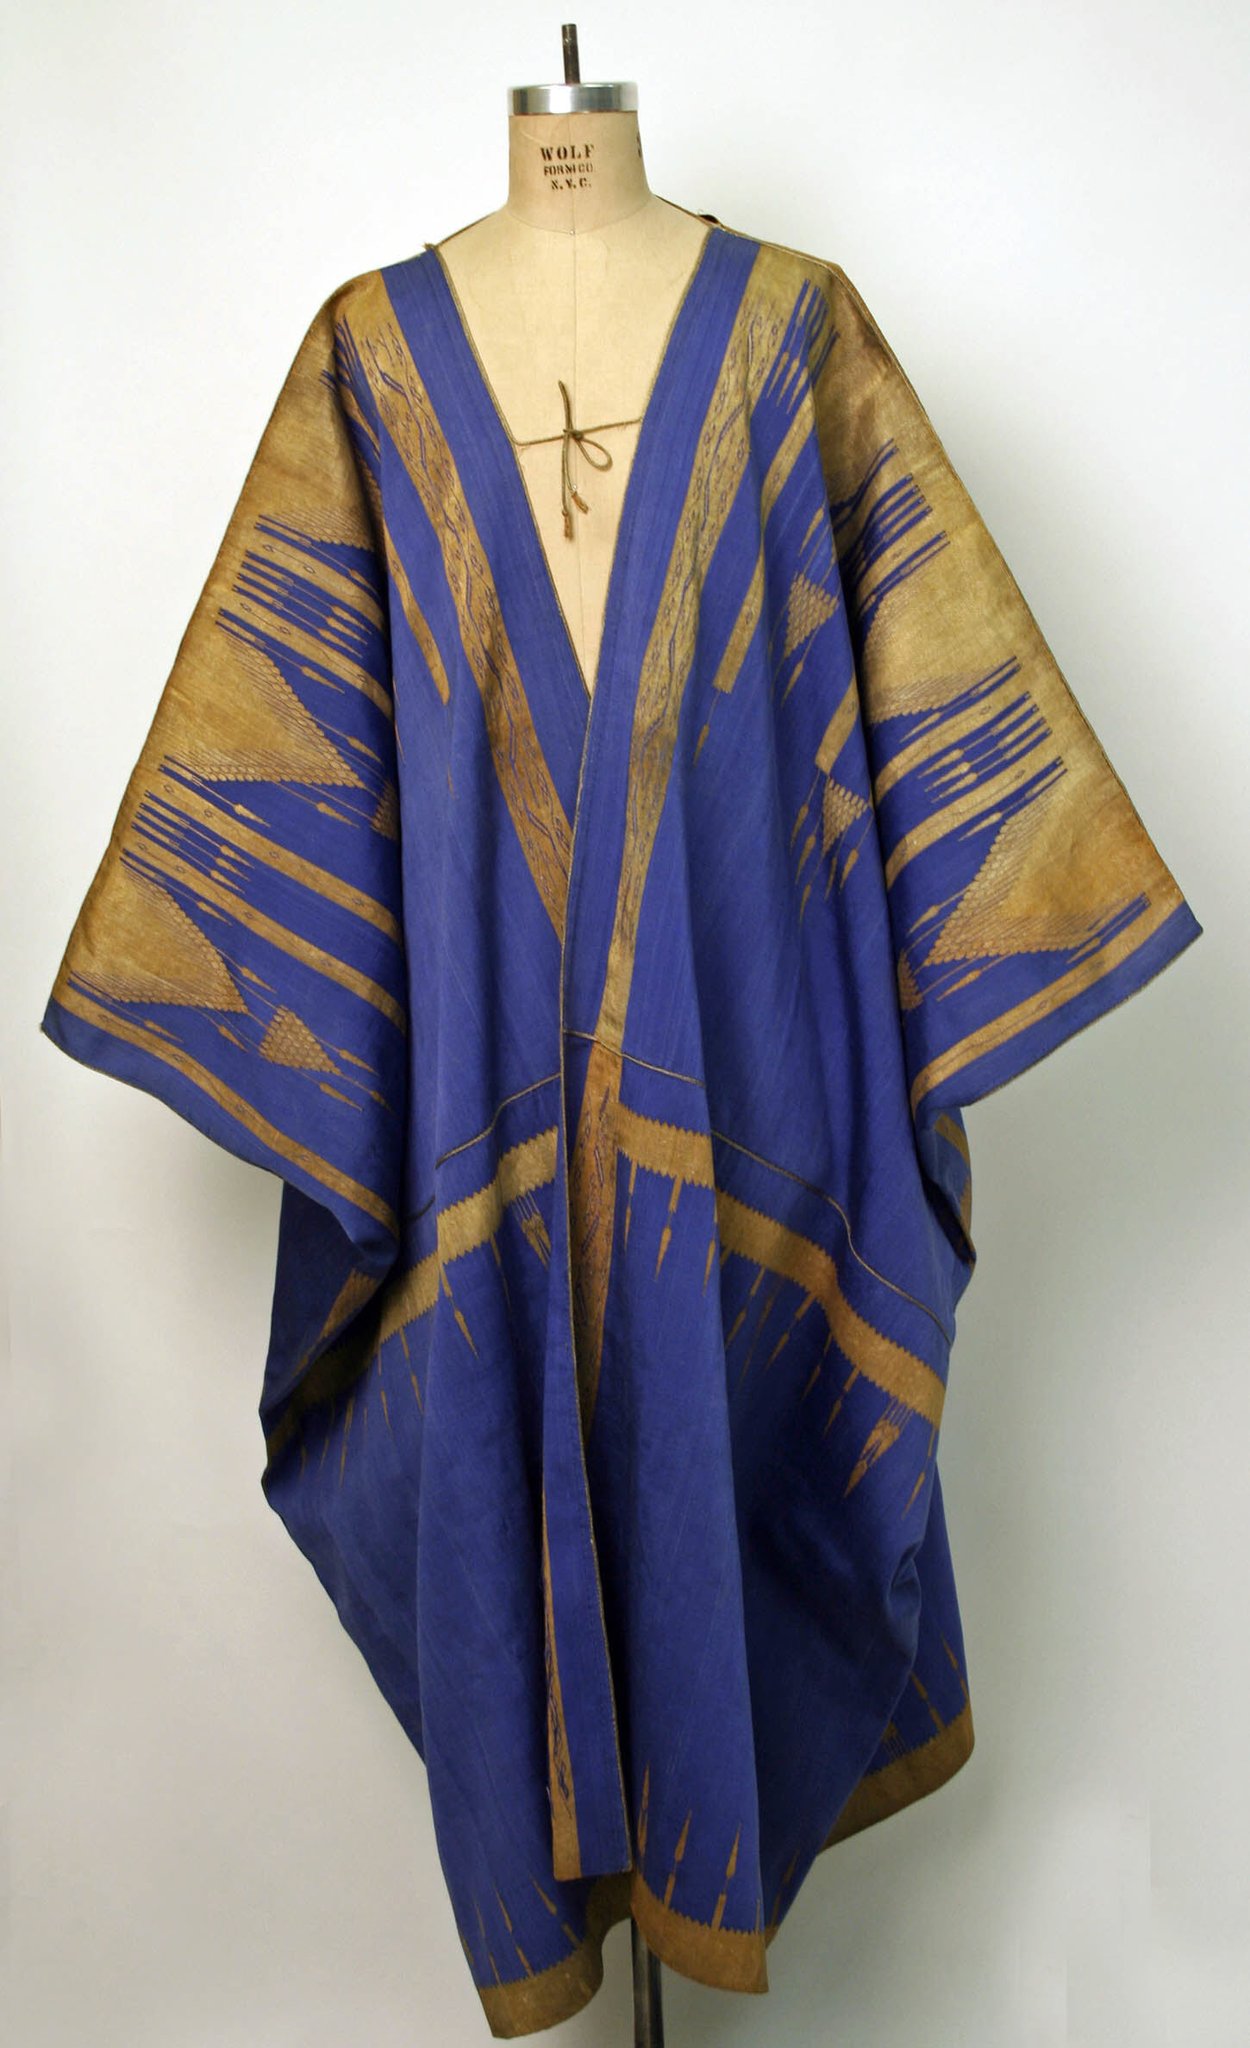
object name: cloak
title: Abaya Cloak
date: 1867-1933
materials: cotton, metal thread, silk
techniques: weave, tapestry weave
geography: syria